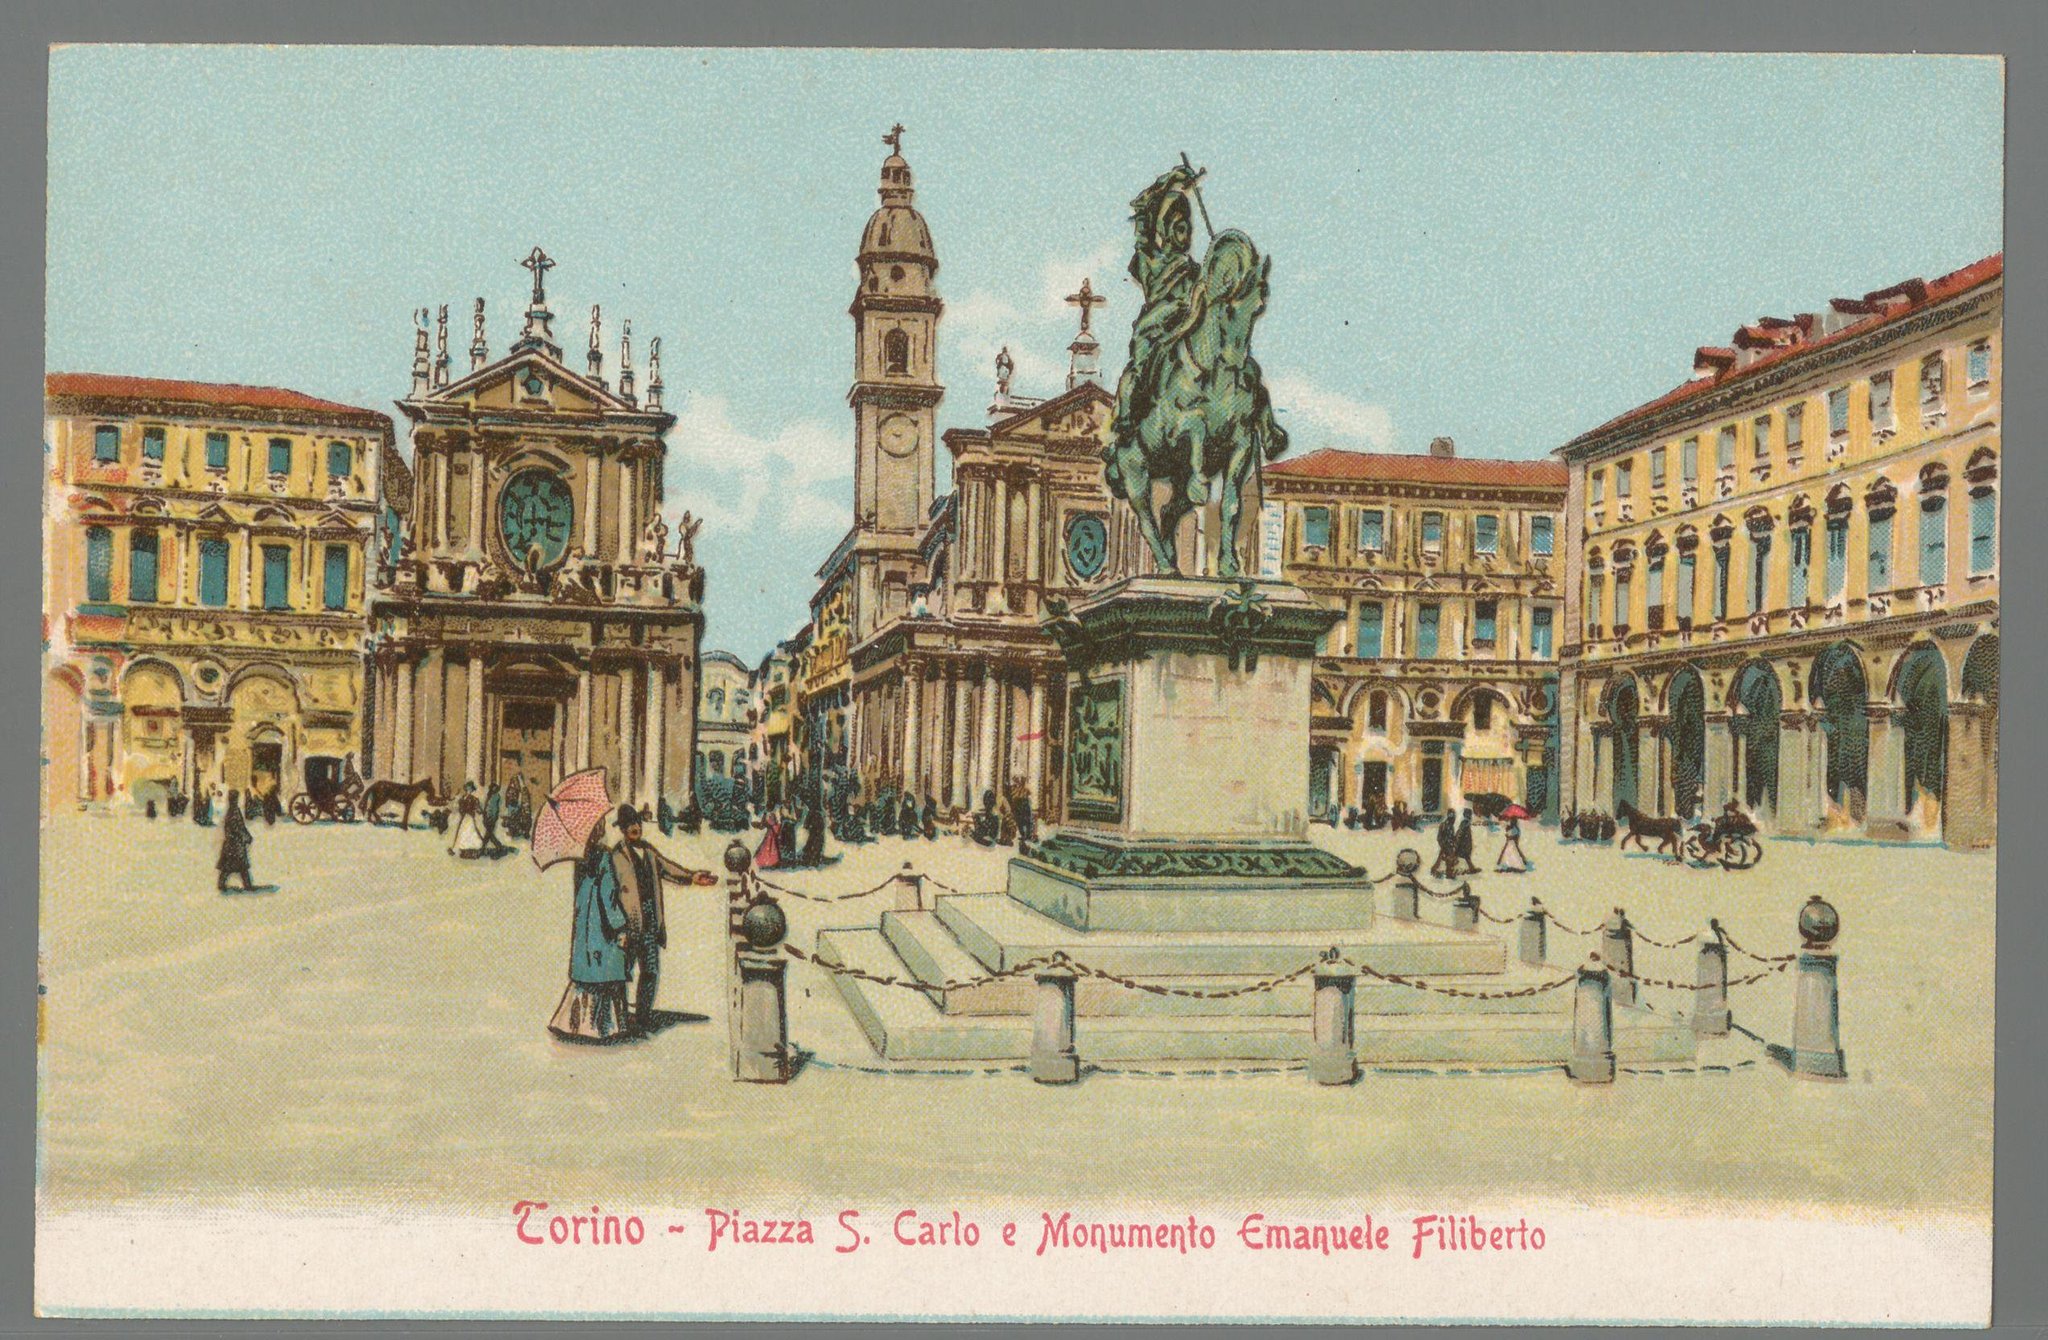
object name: print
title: Torino. Piazza S. Carlo e Monumento Emanuele Filiberto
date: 1906-1920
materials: cardboard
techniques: lithograph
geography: venice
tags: monument, statue, square, place, circus, etc. (+ city(-scape) with figures, staffage)